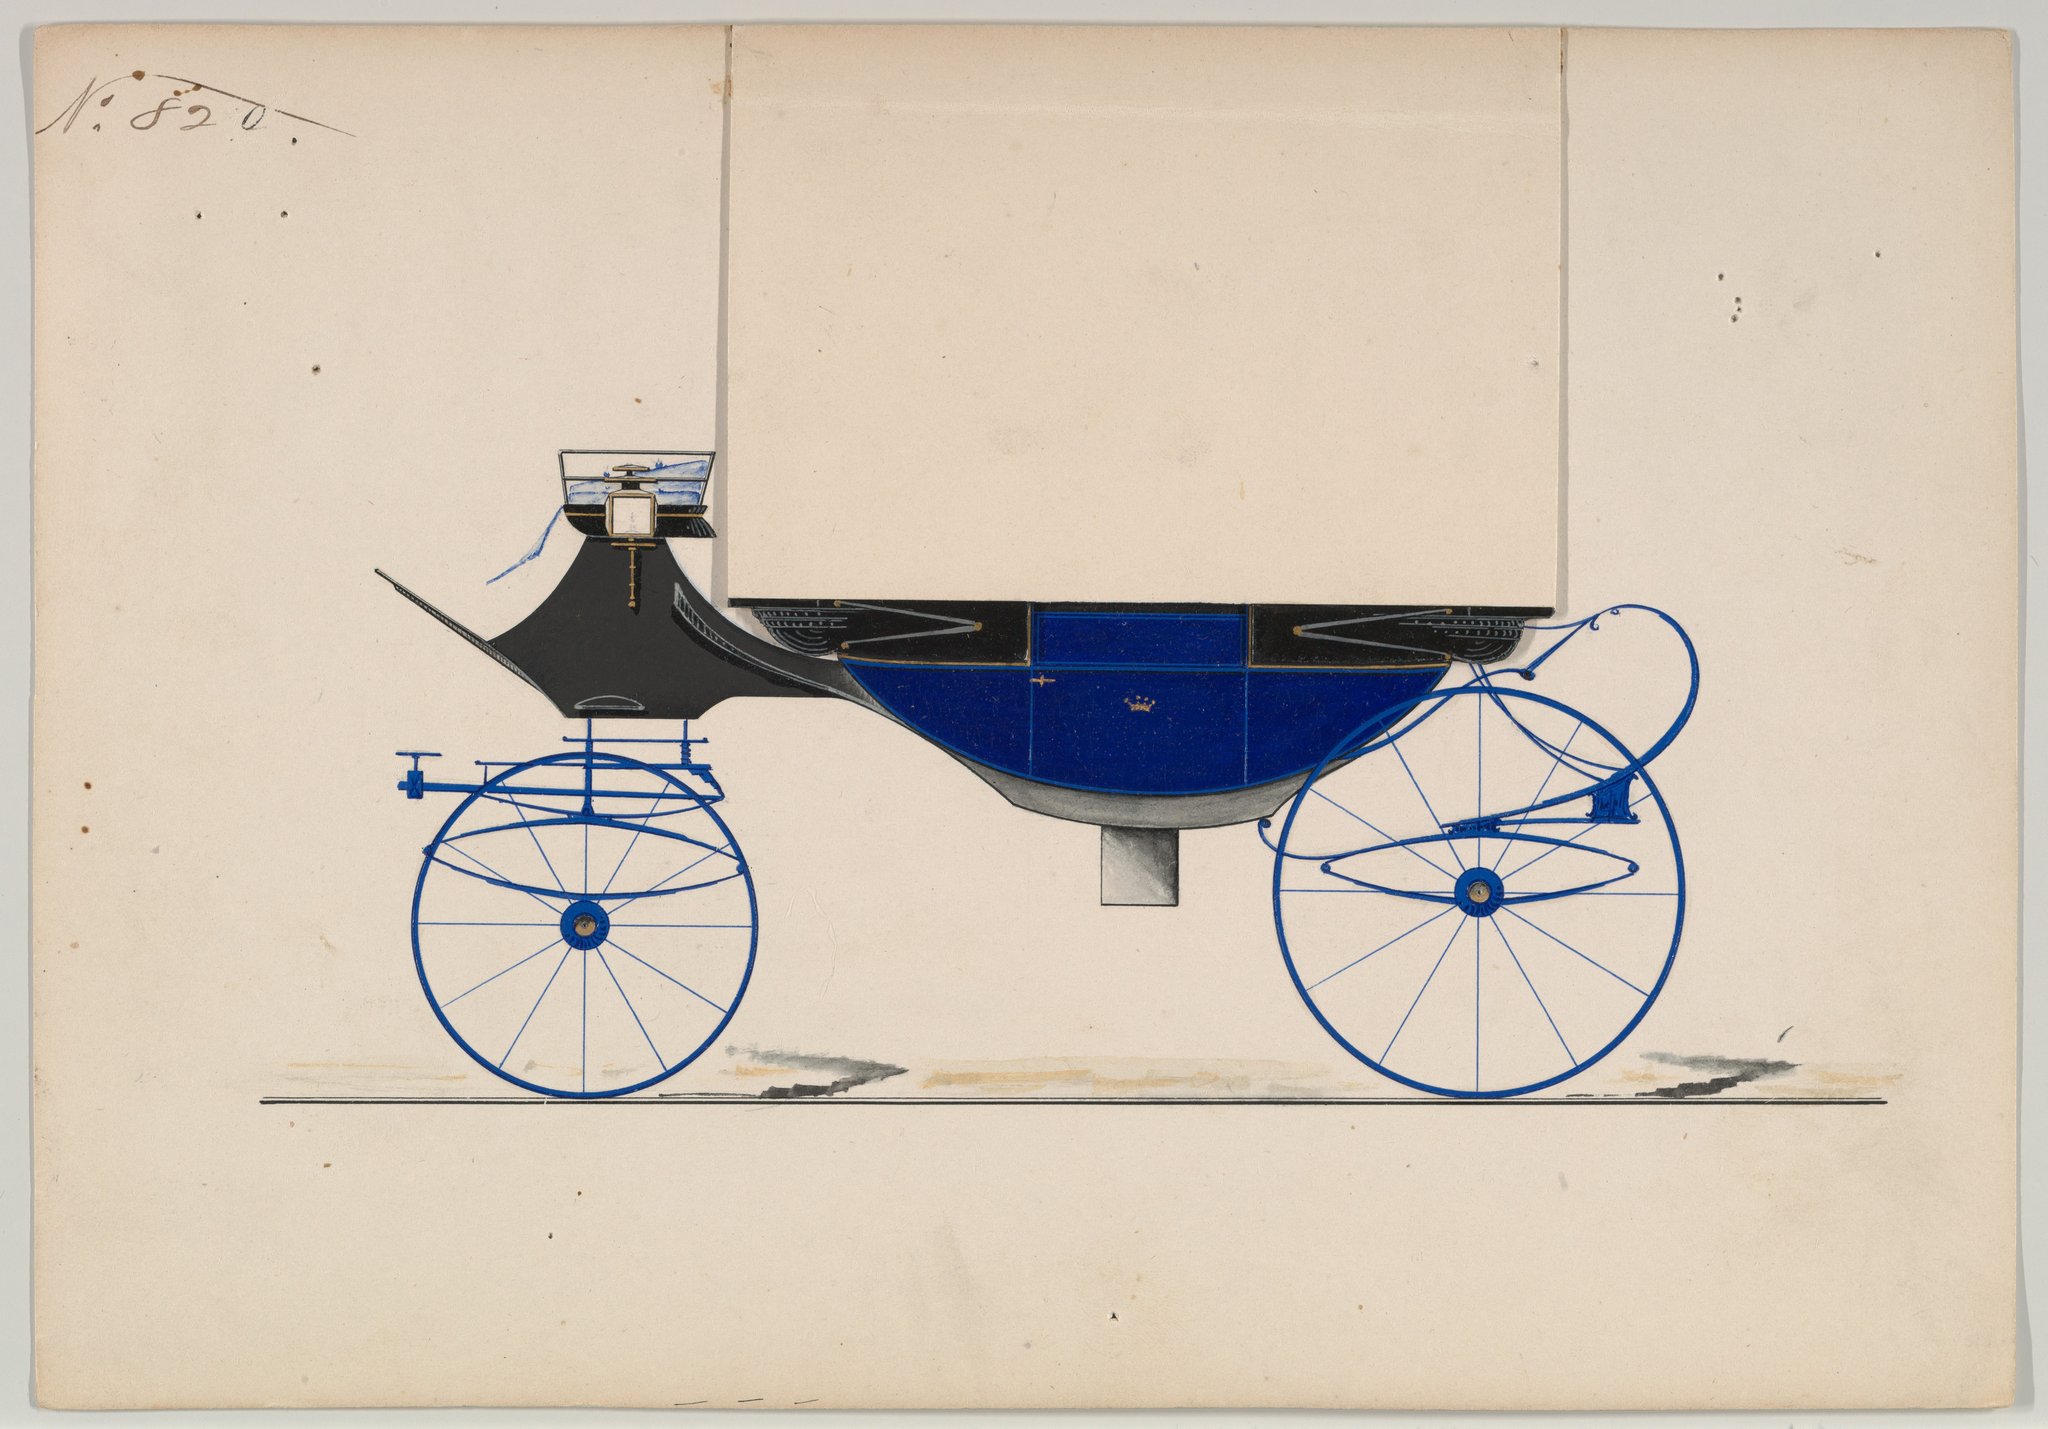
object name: drawing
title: Landau #820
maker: brewster & co.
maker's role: manufacturer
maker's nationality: american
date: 1850-1870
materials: gouache, gum arabic, ink, watercolor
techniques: pen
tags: carriages